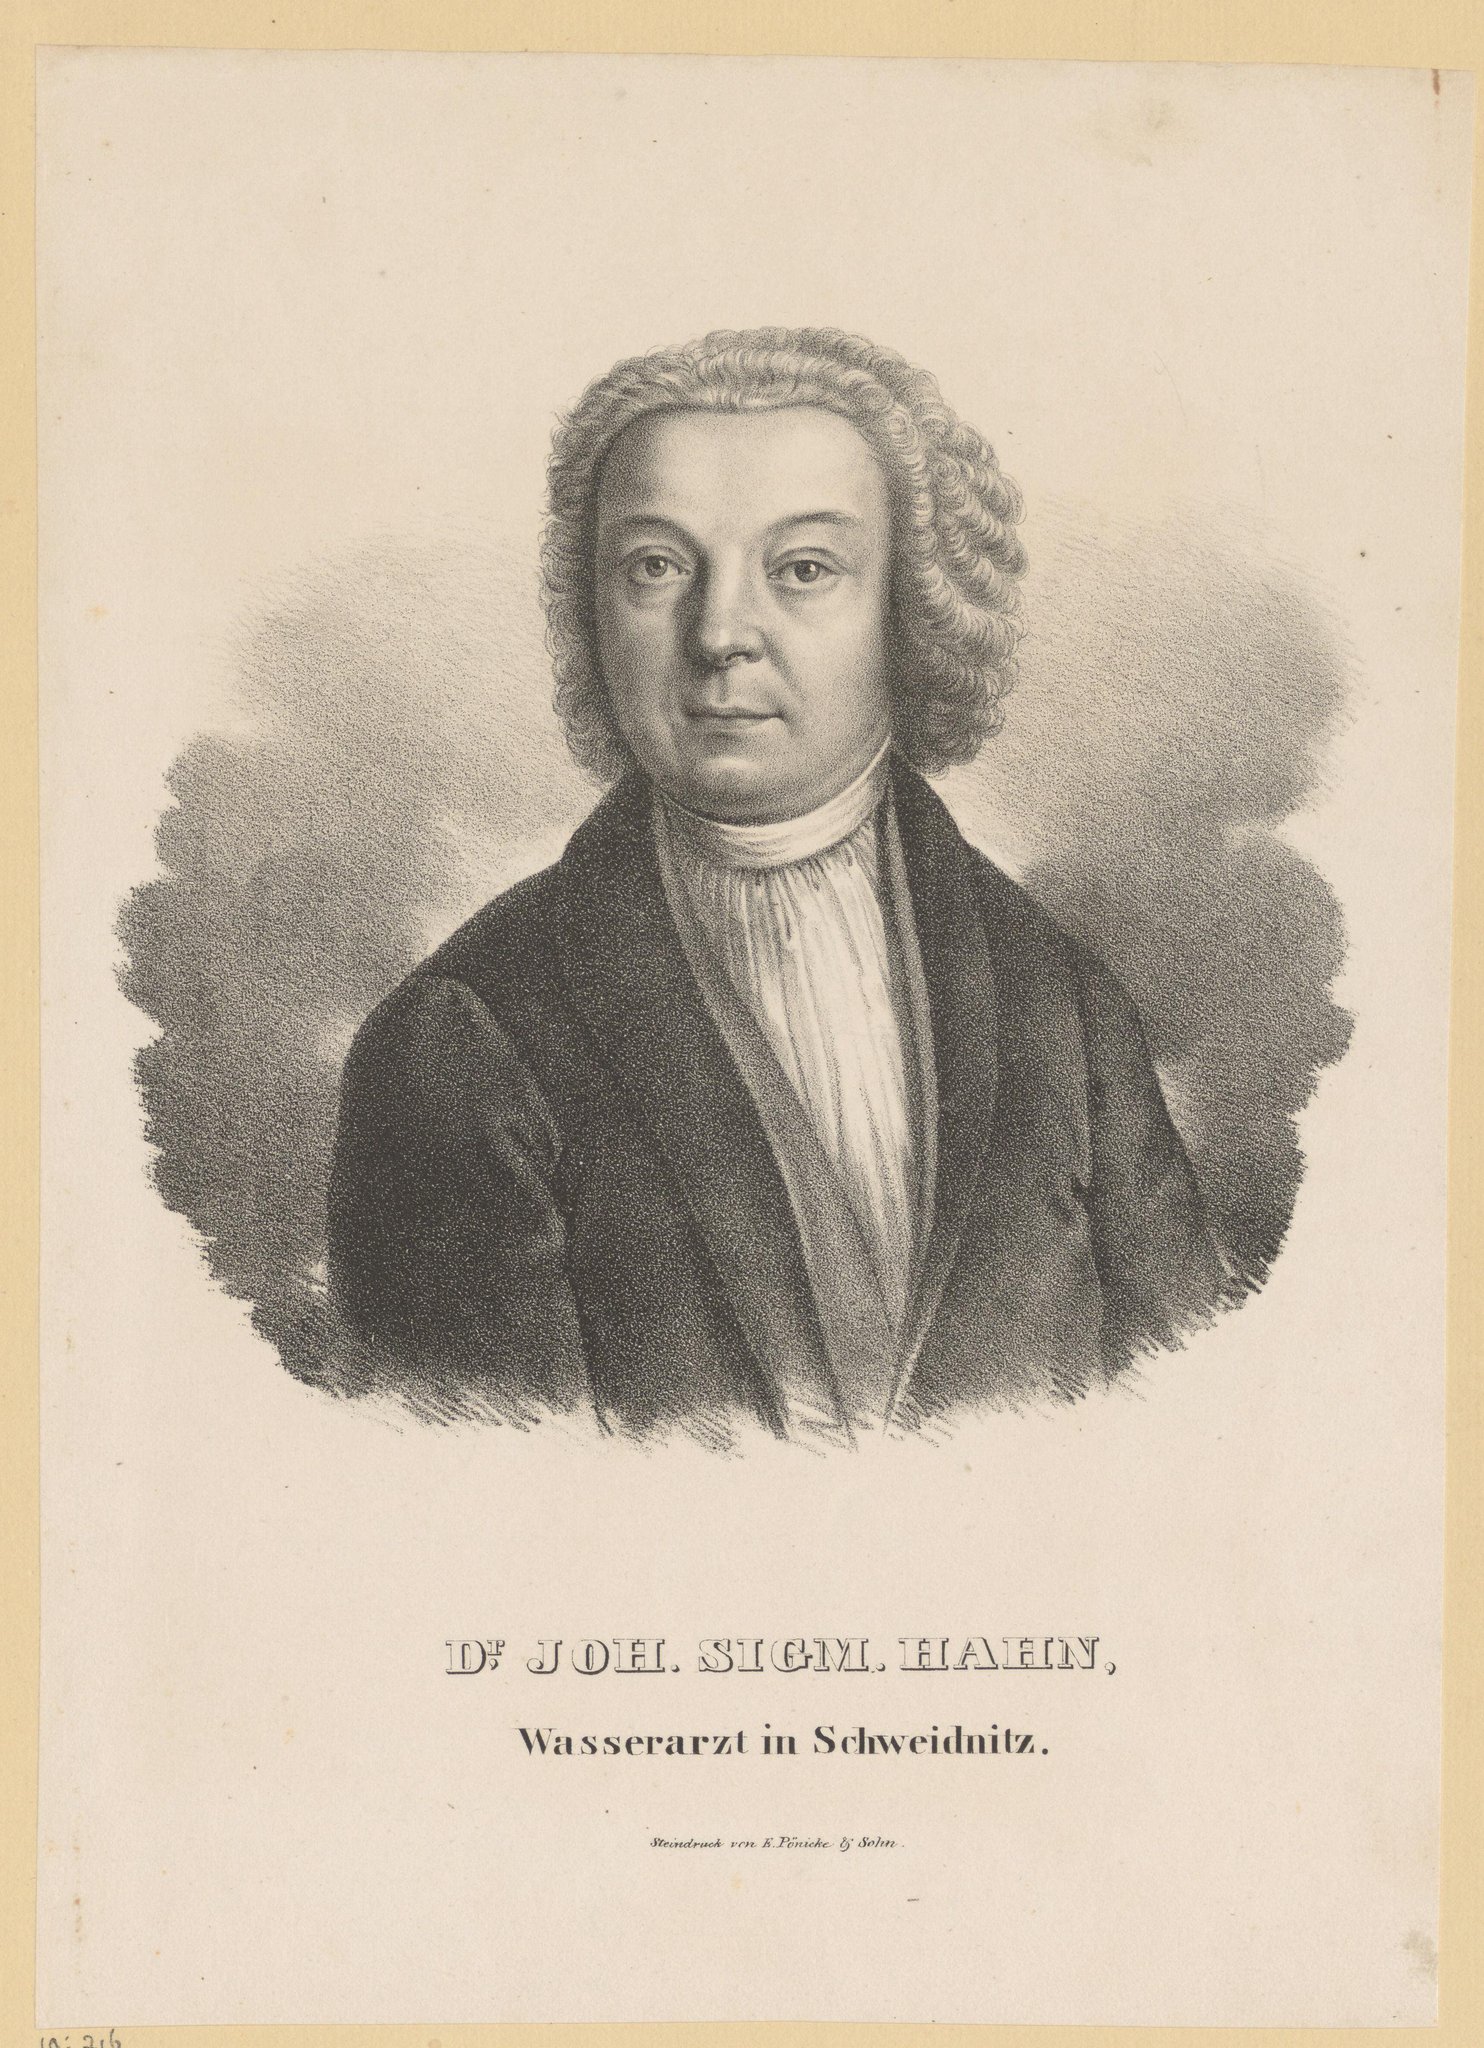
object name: print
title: Portret van Johann Siegmund Hahn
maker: Anonymous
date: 1830-1850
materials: paper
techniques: lithograph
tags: adult man, historical persons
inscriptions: collector's mark: Lugt 2228